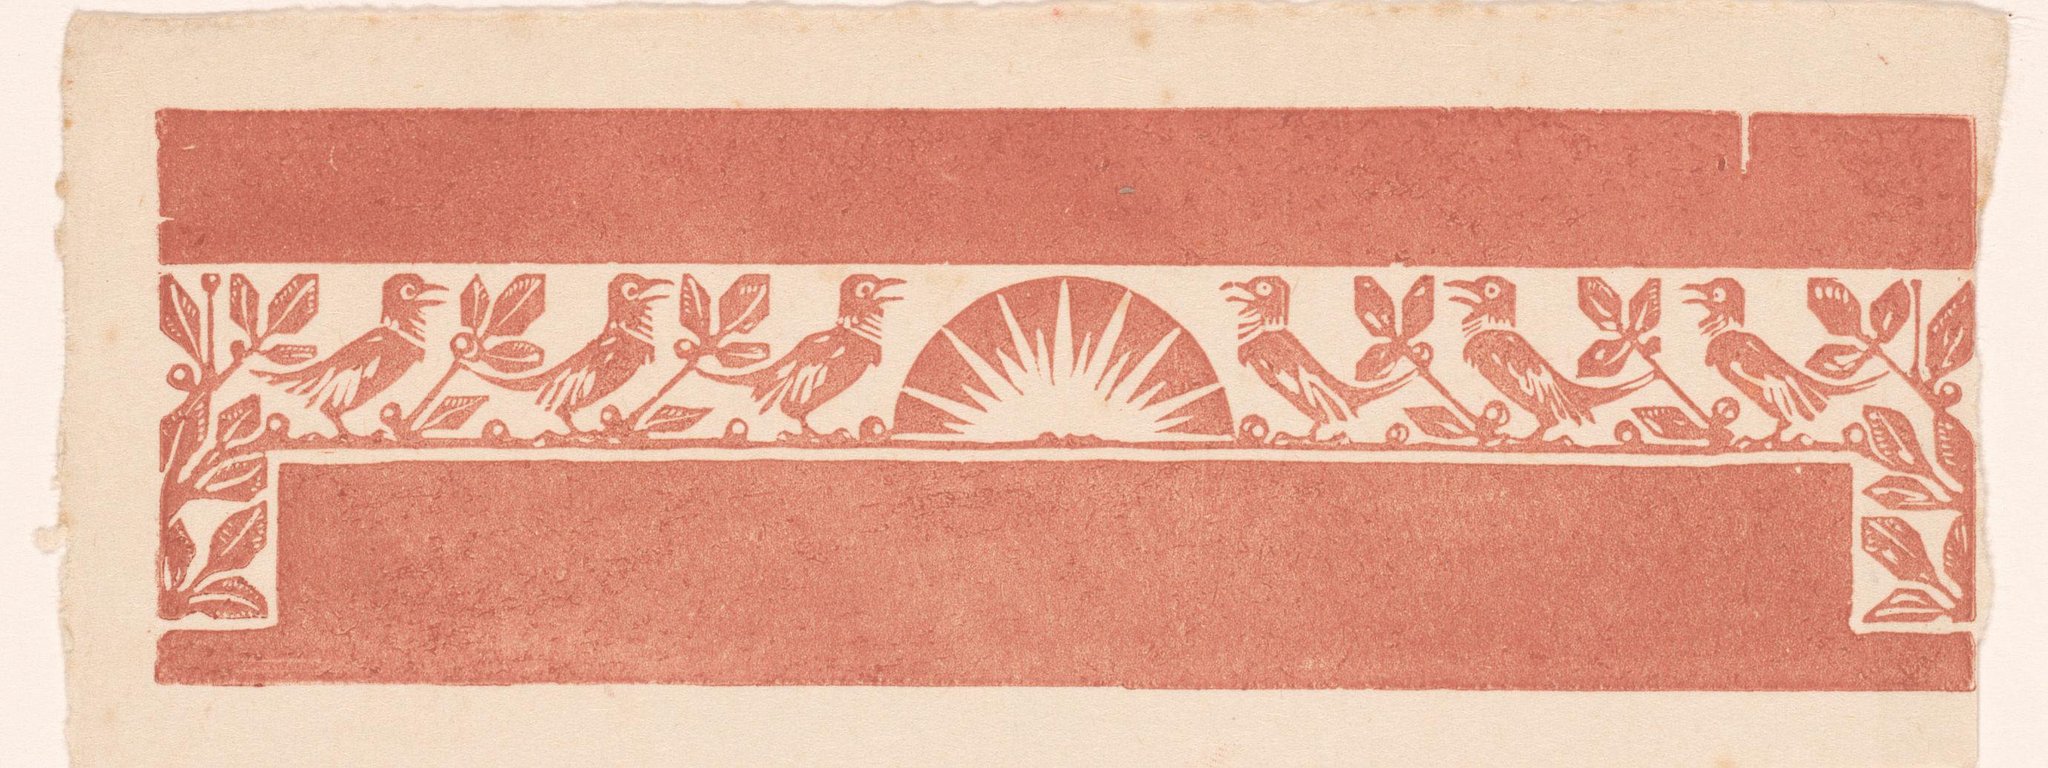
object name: boekillustratie ontwerp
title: Ornamentele rand met bladeren, vogels en zon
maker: bernard willem wierink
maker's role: draughtsman, print maker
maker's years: 1856-1939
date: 1910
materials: paper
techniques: relief print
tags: ornaments ~ art, sunrise, fable of reynard the fox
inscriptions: collector's mark: Lugt 2228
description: Ontwerp voor: Streuvels, Stijn (Frank Lateur). Reinaert de Vos naar verschillende uitgaven van het middeleeuwsche epos. Amsterdam: L.J. Veen, 1910. Deze prent is vermoedelijk een plaatsnede, ook al wordt in de literatuur veelal gesproken over een houtsnede. Voor zover Wierink zijn prenten in hoogdruk zelf nader heeft omschreven, heeft hij altijd de term 'plaatsnede' gebruikt.